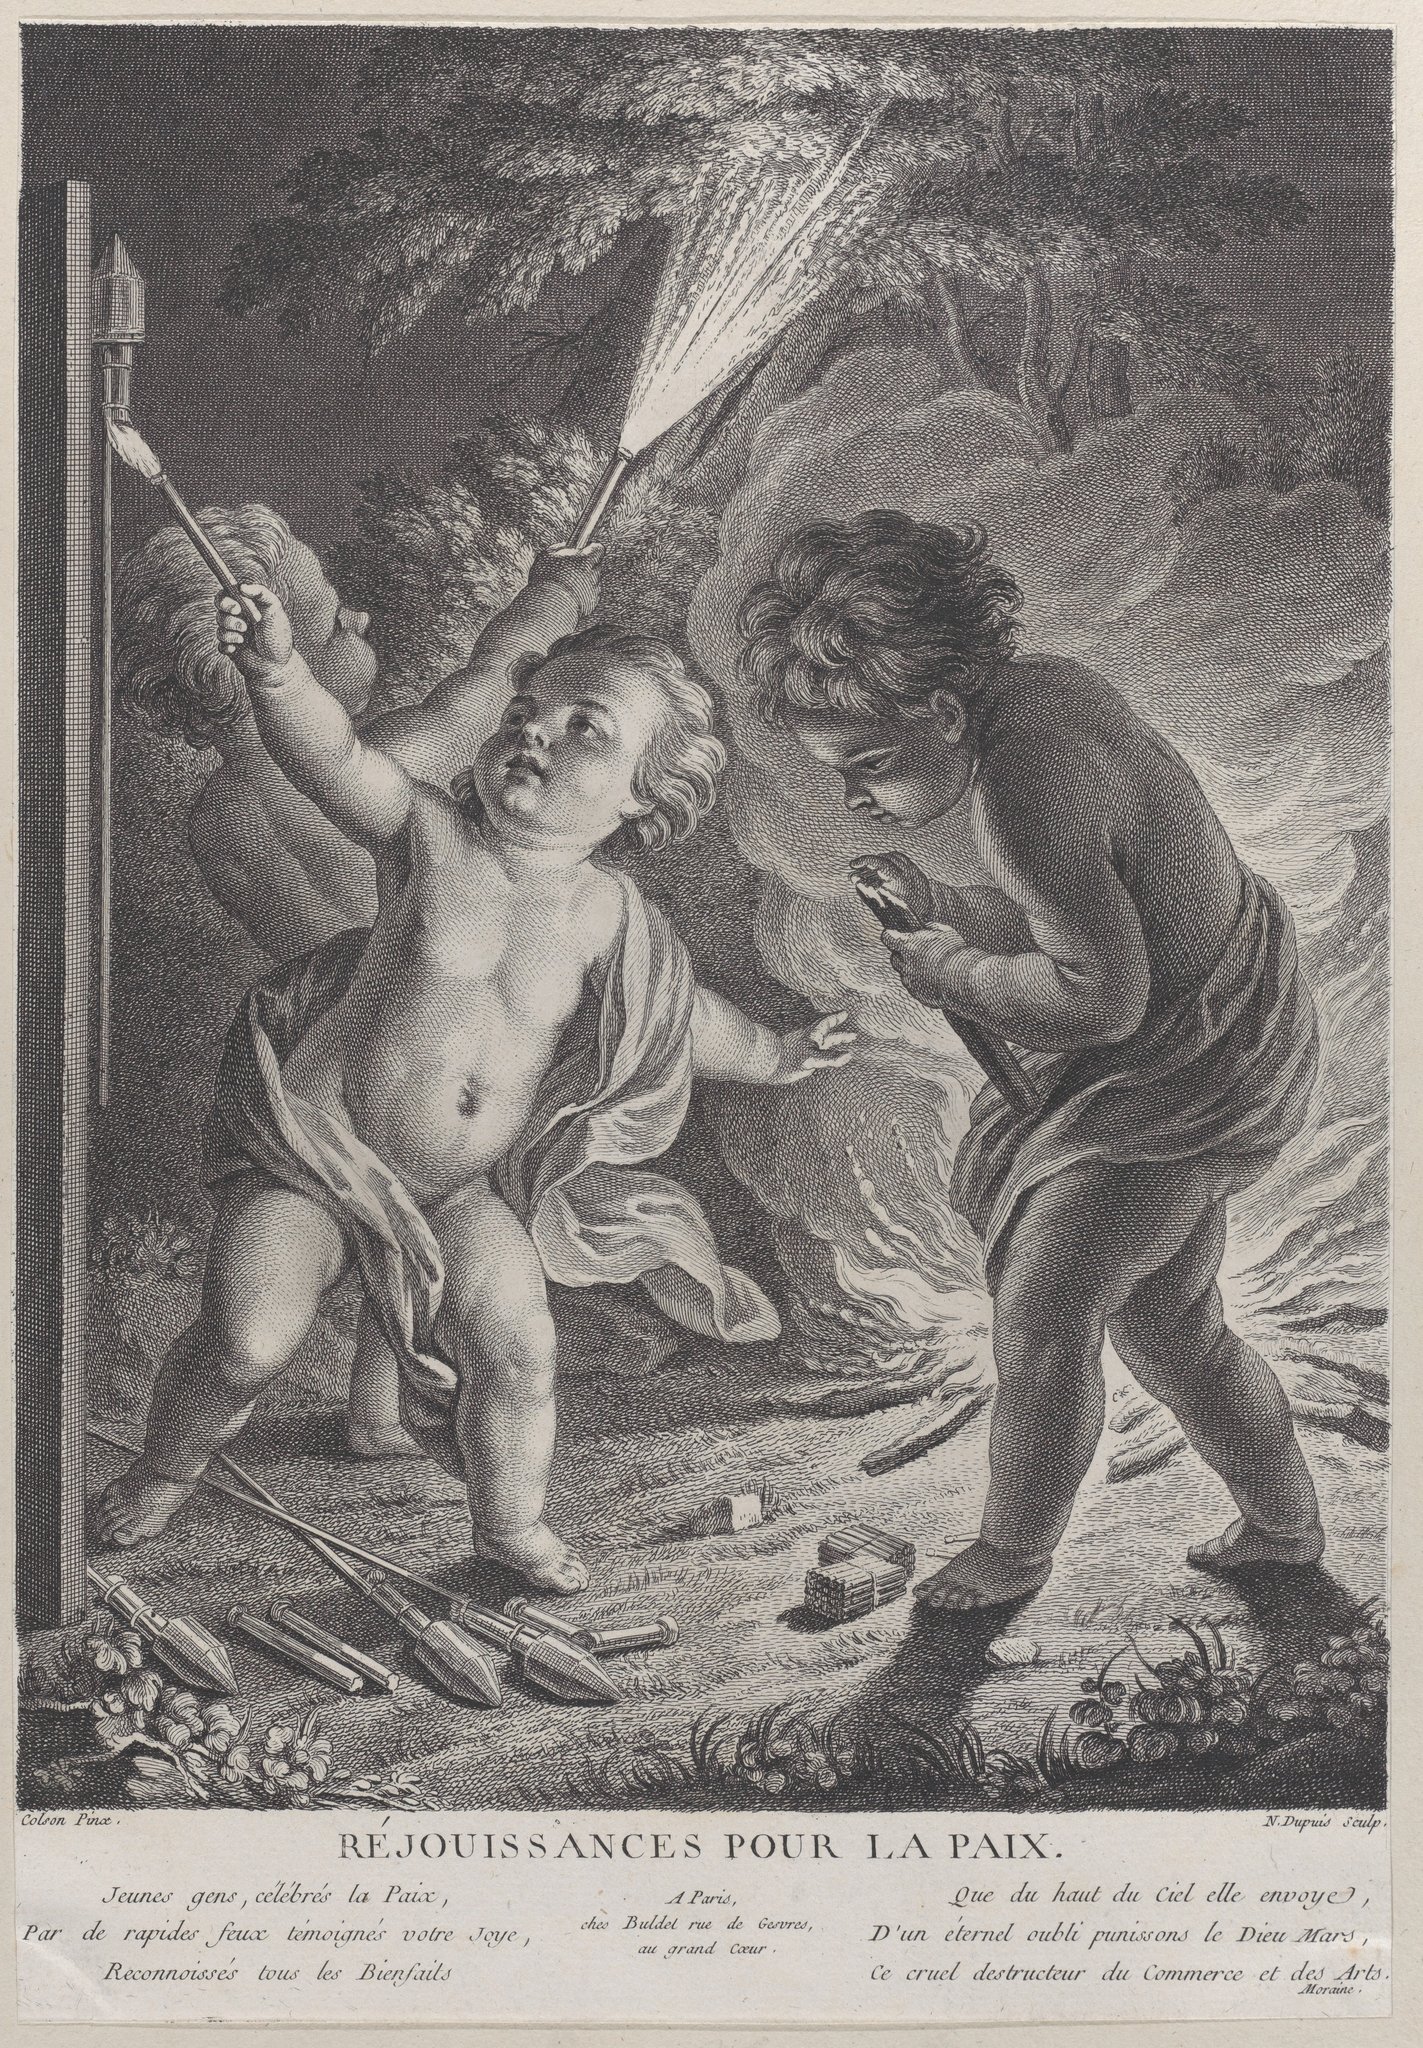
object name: print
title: Celebrating Peace (Réjouissances pour la paix), three putti with fireworks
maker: nicolas gabriel dupuis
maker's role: artist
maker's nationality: french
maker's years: 1698-1771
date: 1745-1771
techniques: engraving, etching